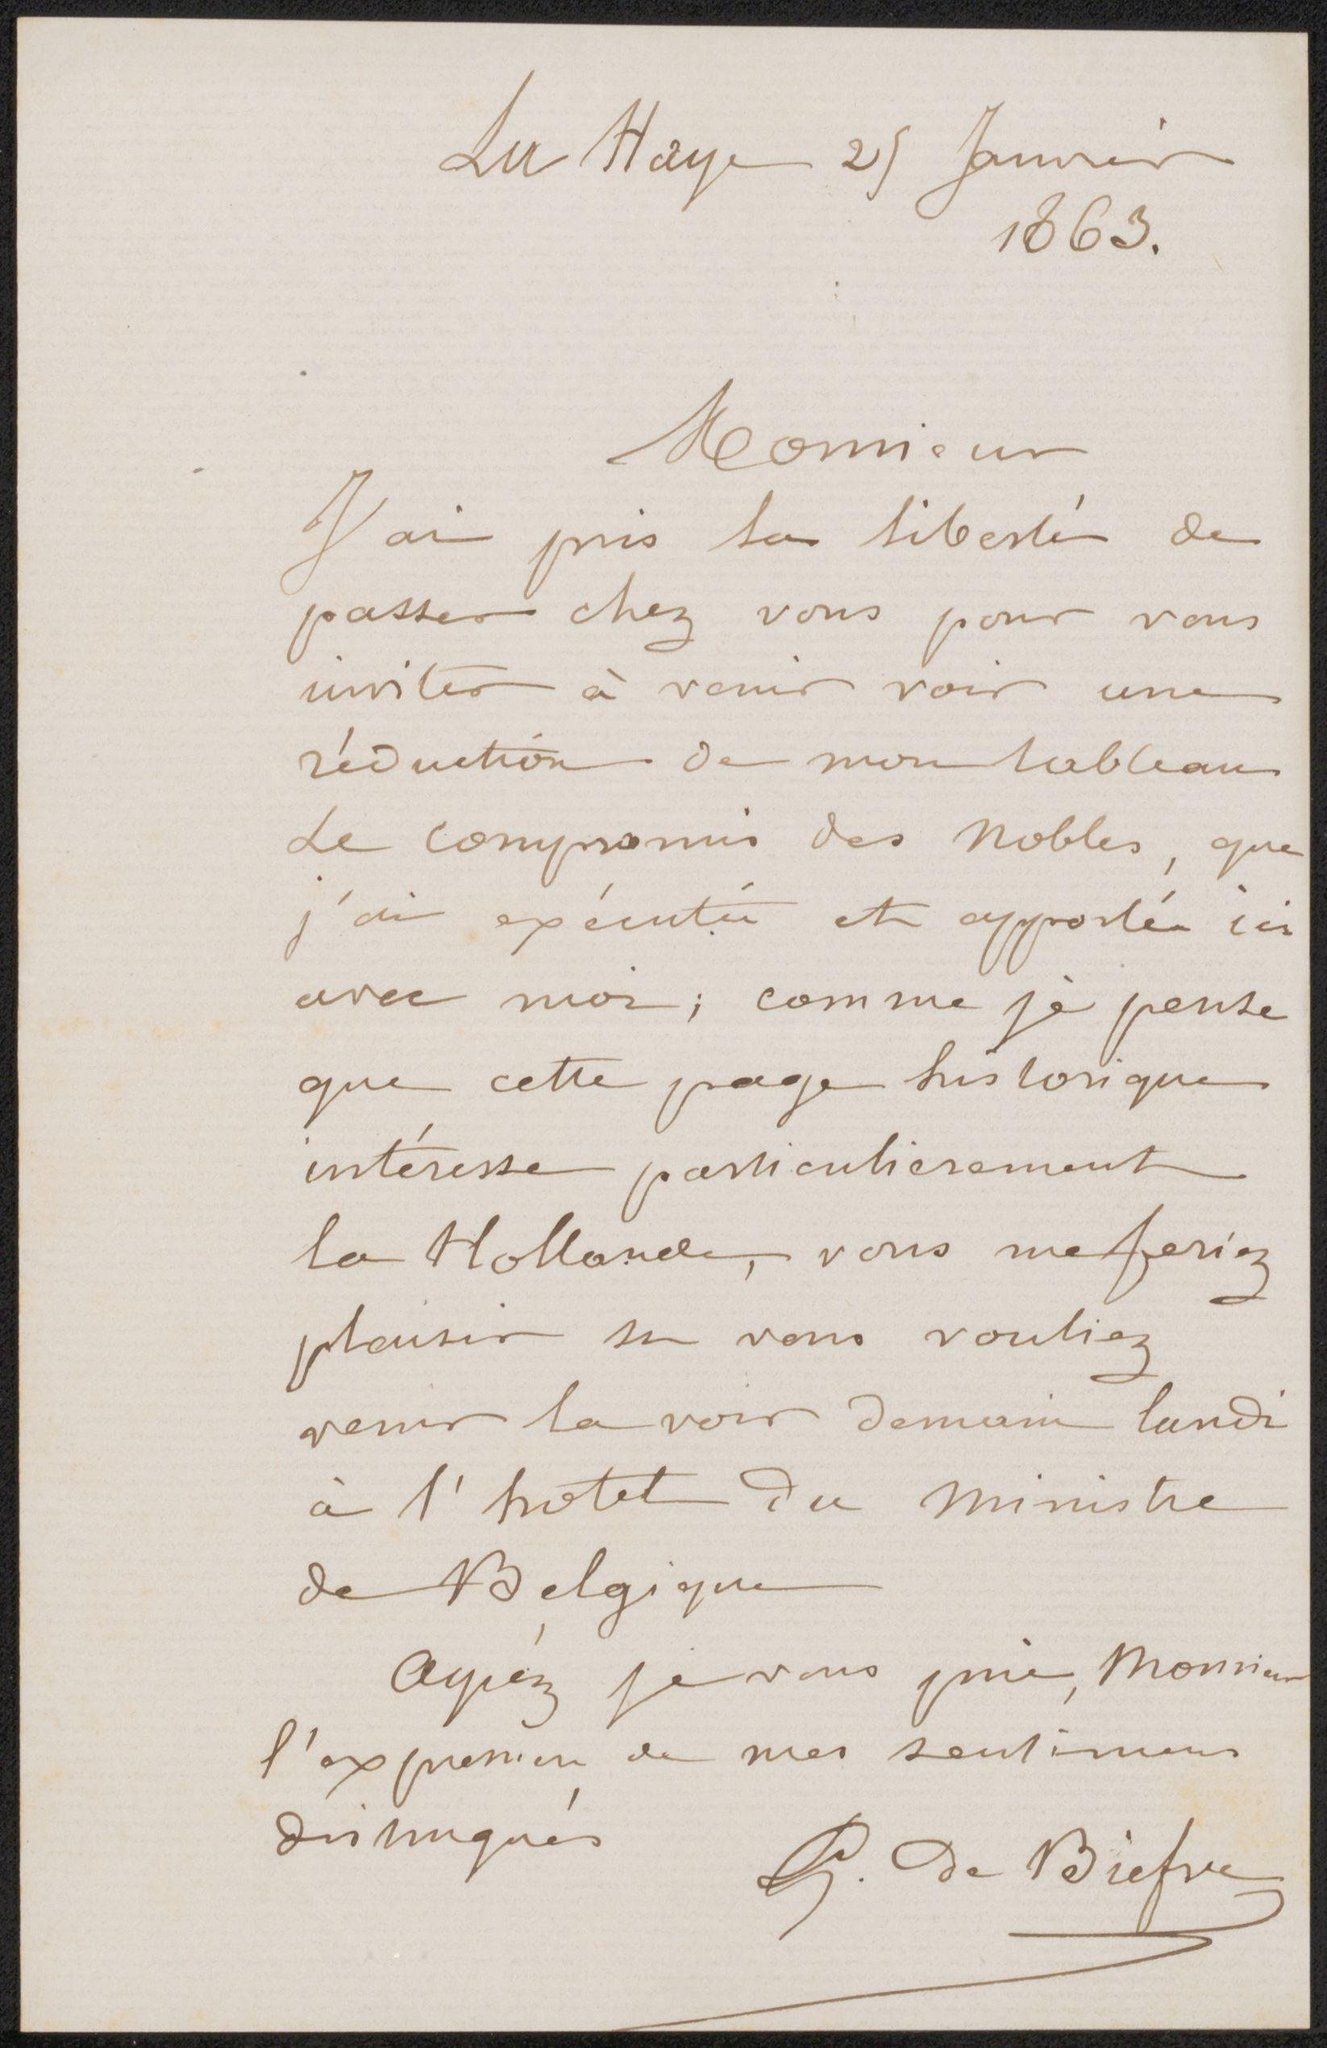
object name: letter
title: Brief aan Ary Johannes Lamme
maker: edouard de biefve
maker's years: 1808-1882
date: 1863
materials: ink, paper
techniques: pen, writing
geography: the hague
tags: dordrecht, print maker, draughtsman, ary johannes lamme, painting (including book-illumination, miniature-painting)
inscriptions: collector's mark: Lugt 2228